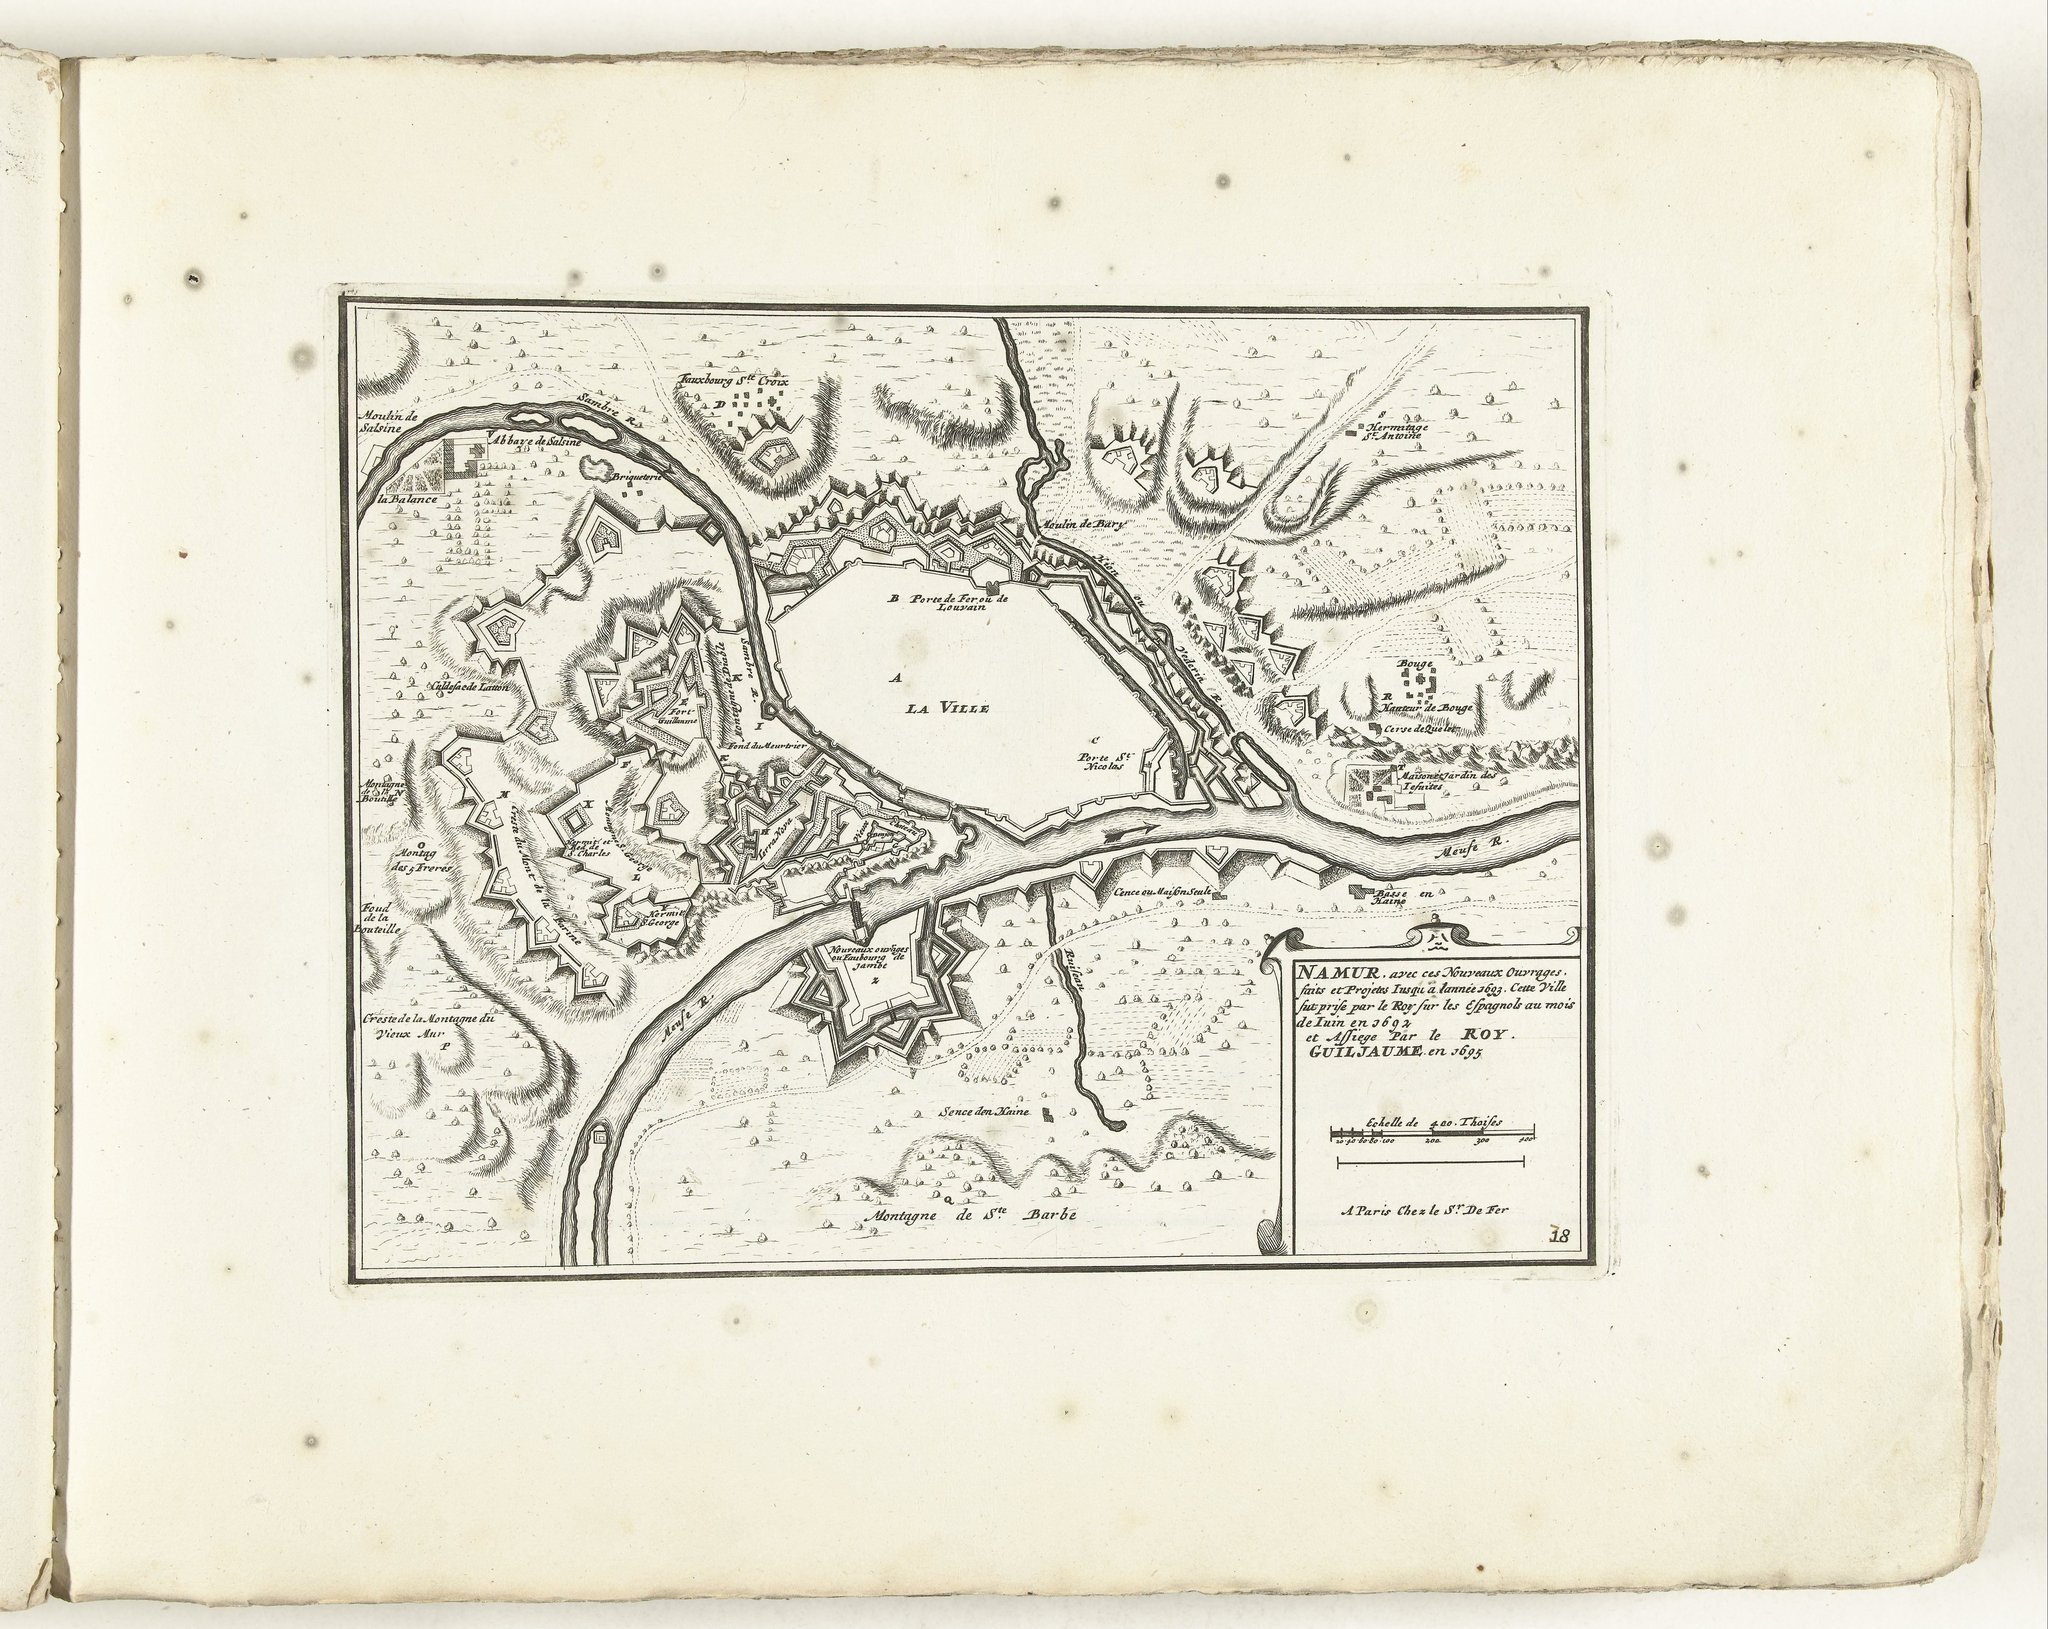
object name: print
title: Plattegrond van Namen, ca. 1702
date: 1702-1703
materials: paper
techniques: etching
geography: northern netherlands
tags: fortress, maps of cities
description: Plattegrond van de verdedigingswerken om de stad Namen, belegerd door de geallieerden in 1695. Rechtsonder oud nummer: 18. Plaat nr. 38 in het prentwerk bestaande in totaal uit 276 genummerde platen van vermaarde sterke steden en vestingen in het kader van de Spaanse Successieoorlog. Voor het merendeel zijn deze platen gekopieerd naar de anonieme Franse platen: in Les forces de l'Europe en in: Le theatre de la guerre, dans les Pays-Bas, beide oorspronkelijk uitgegeven door Nicolas de Fer te Parijs (1693-1697) in het kader van de Negenjarige Oorlog. Titel en opschriften in de plaat in het Frans.